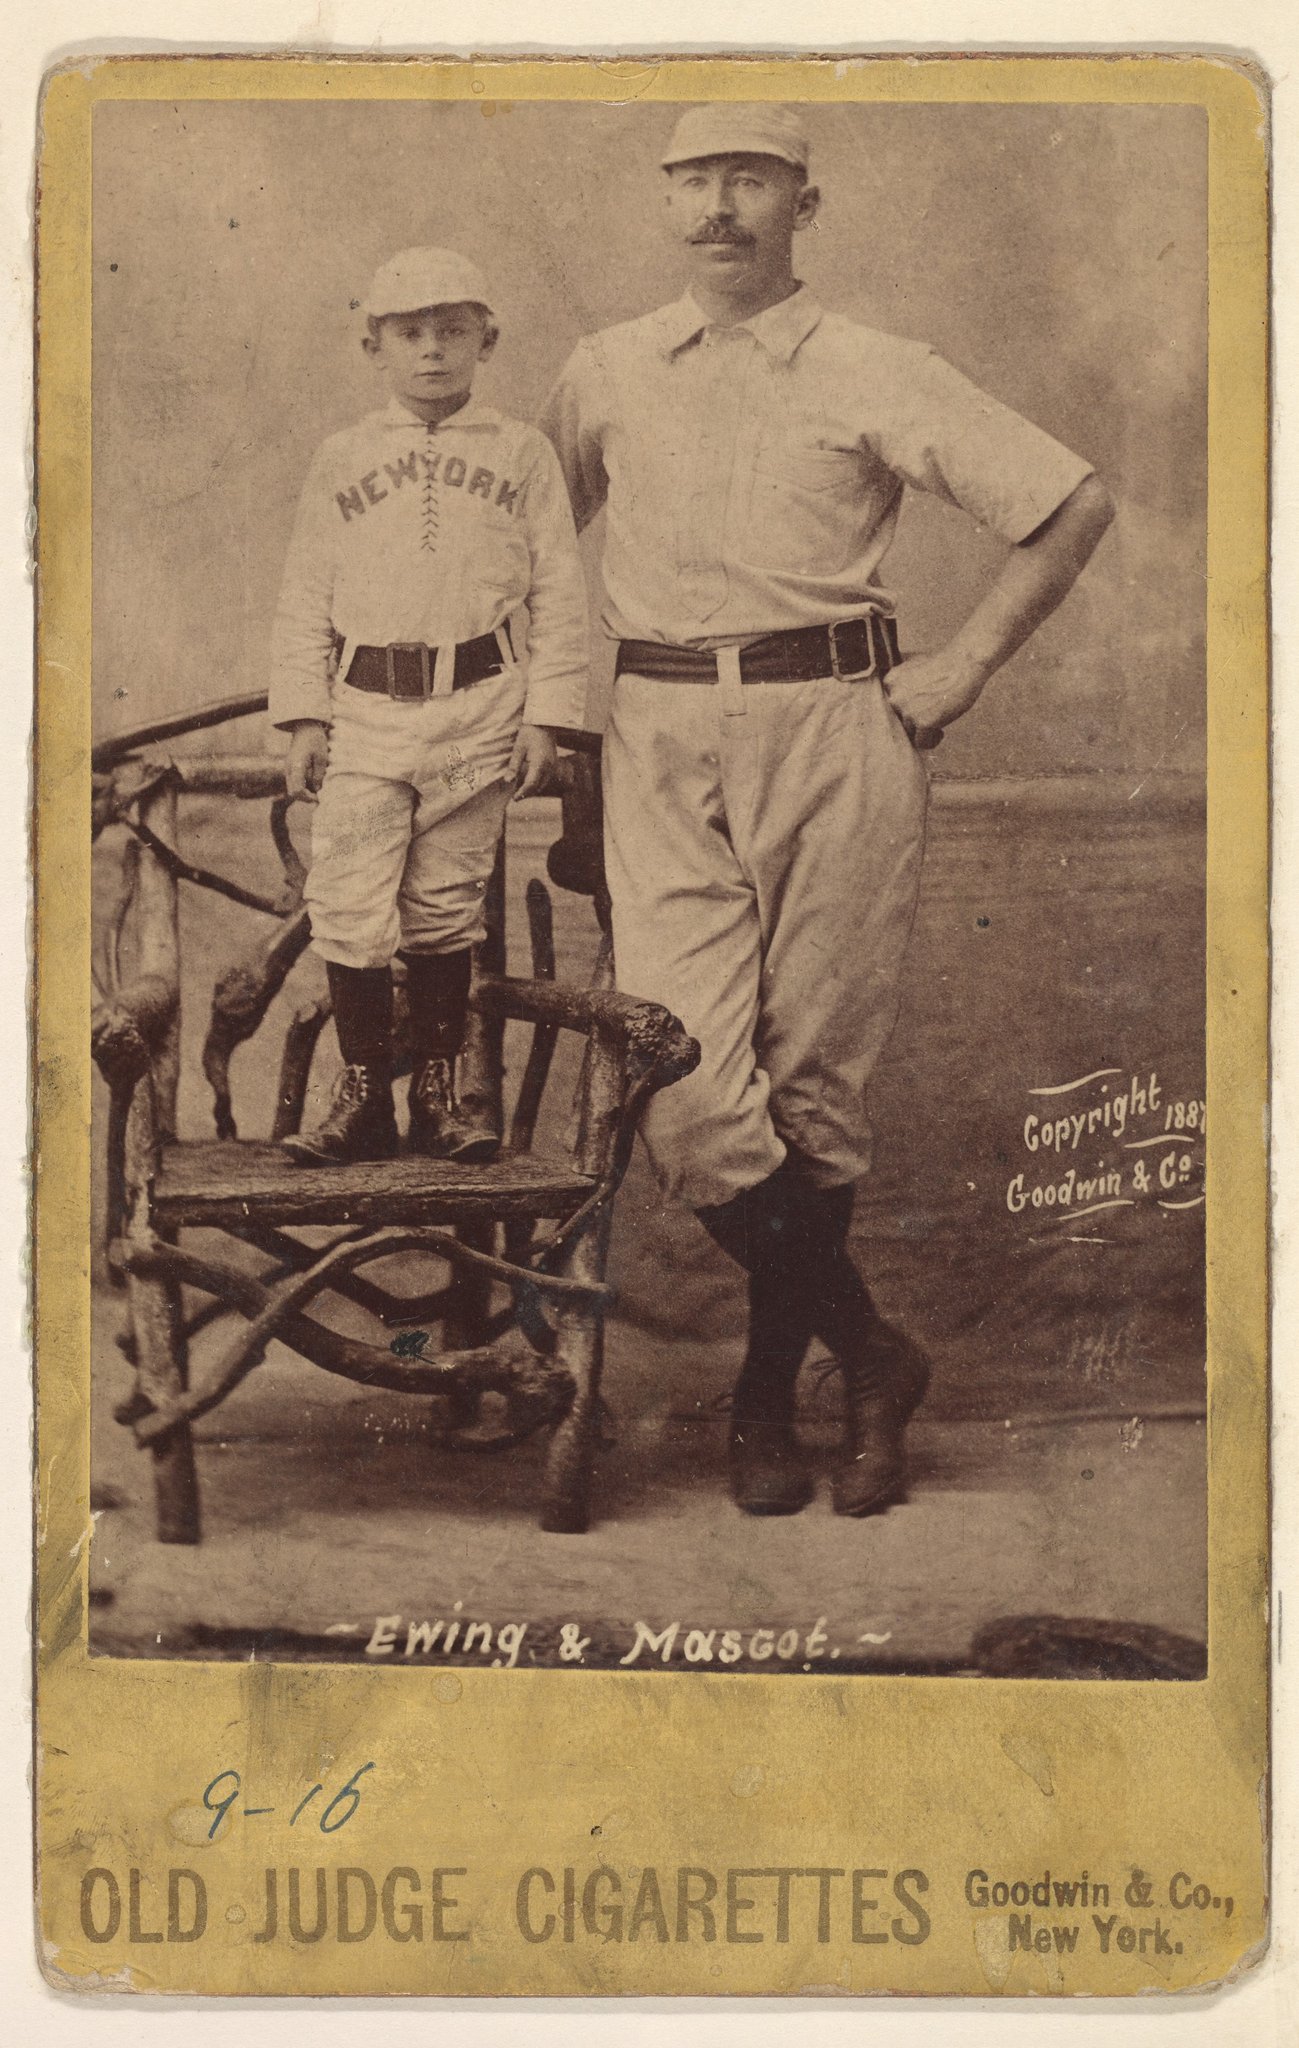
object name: baseball card, photograph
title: Ewing and Mascot, New York, from the series Old Judge Cigarettes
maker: goodwin & company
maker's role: publisher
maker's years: 1850-1950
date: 1887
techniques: albumen silver print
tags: boys,men,portraits,baseball,athletes